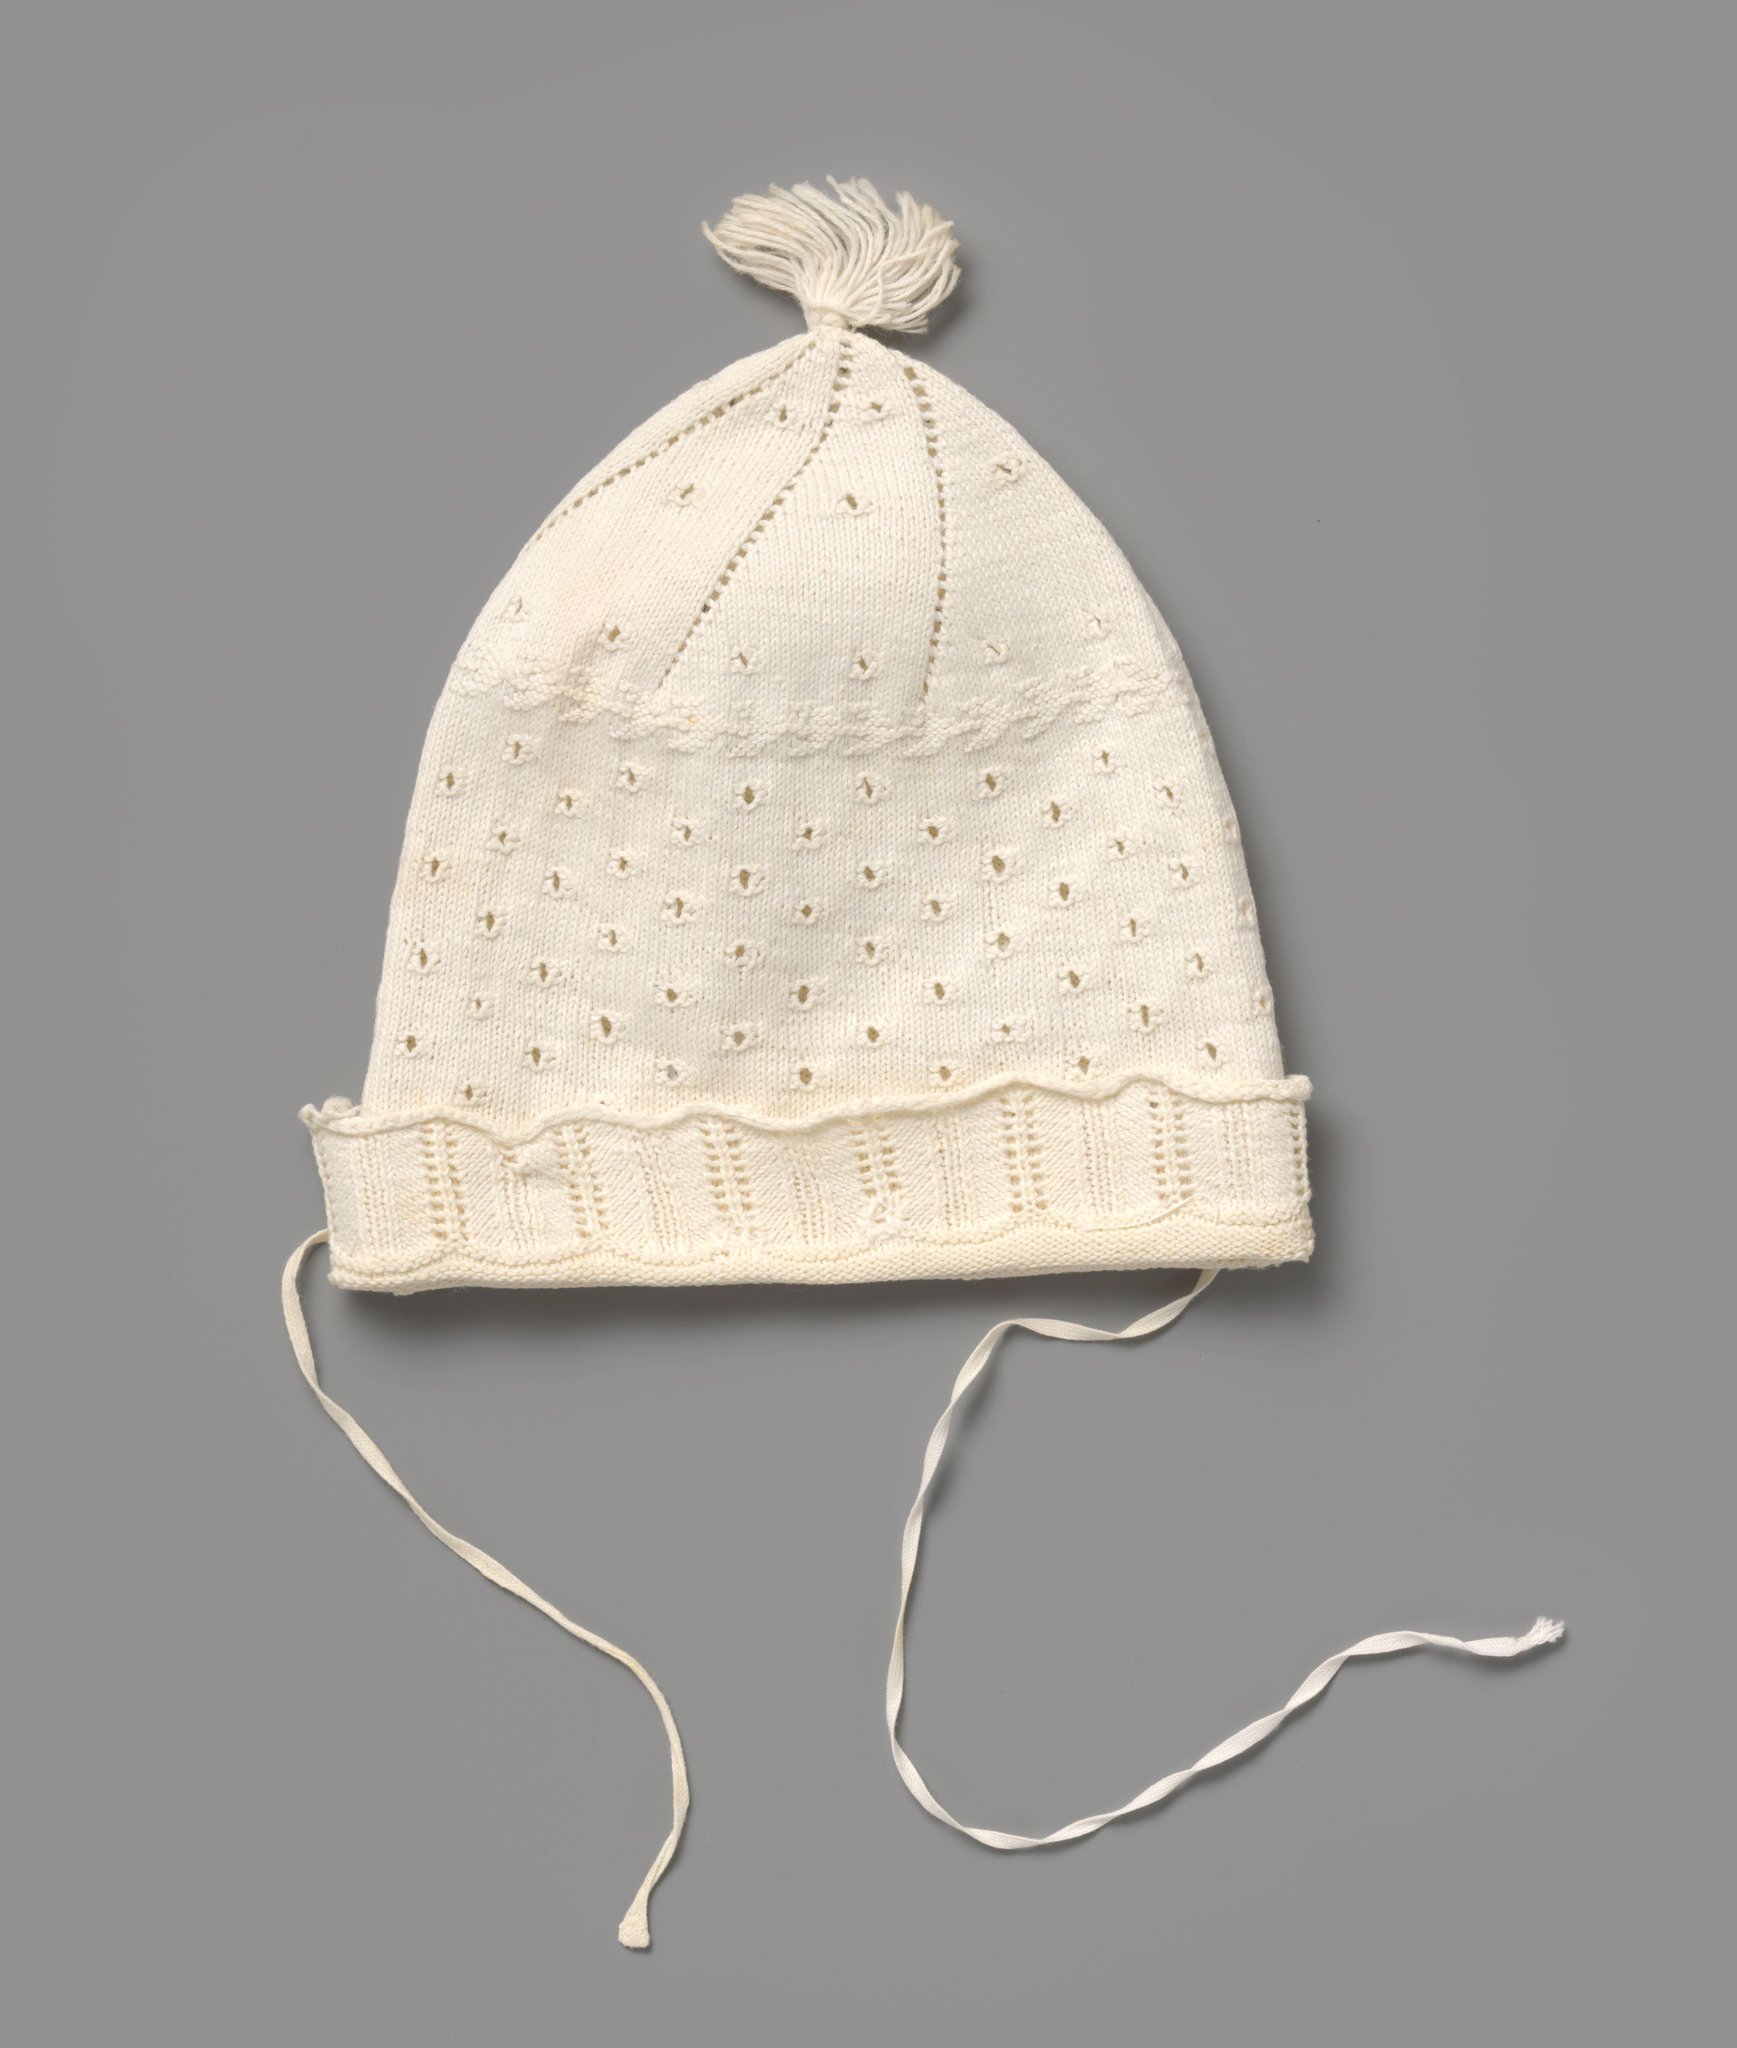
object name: cap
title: Gebreide muts van wit katoen met opengewerkte rondjes, een omgeslagen rand en een kwast bovenop, met rondom uitwaaierende ajourranden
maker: Anonymous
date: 1850-1960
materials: cotton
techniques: embroidery, knitting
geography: europe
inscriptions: label: ‘M. DE CLERCQ’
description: Gebreide muts van wit katoen met opengewerkte rondjes, een omgeslagen rand en een kwast bovenop, met rondom uitwaaierende ajourranden.